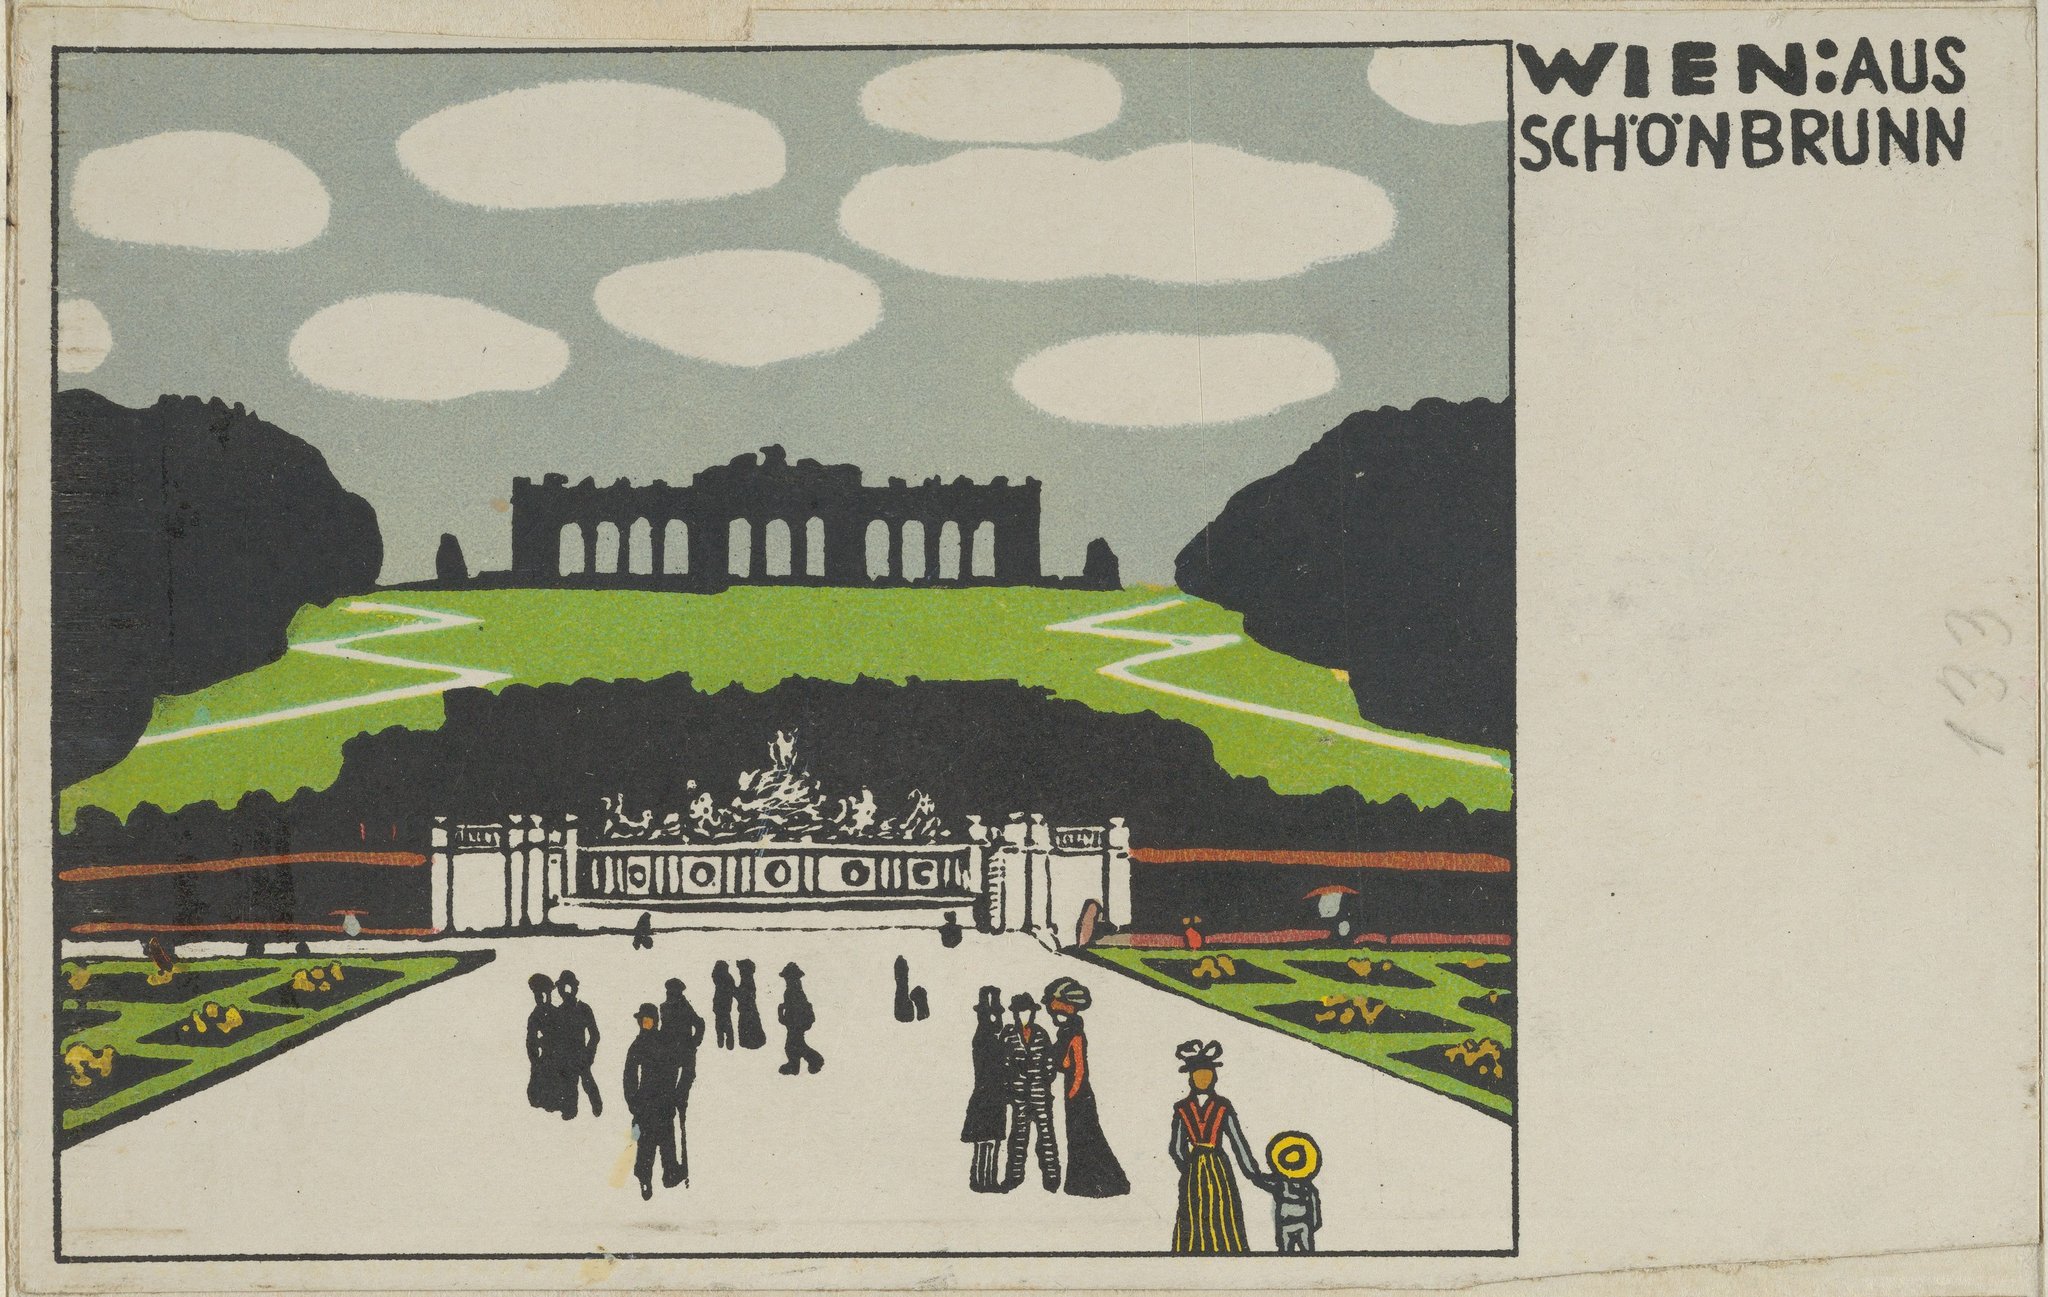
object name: print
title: Vienna: From Schönbrunn (Wien: Aus Schönbrunn)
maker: urban janke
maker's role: artist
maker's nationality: austrian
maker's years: 1887-1914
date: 1908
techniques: lithograph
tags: gardens,children,men,women